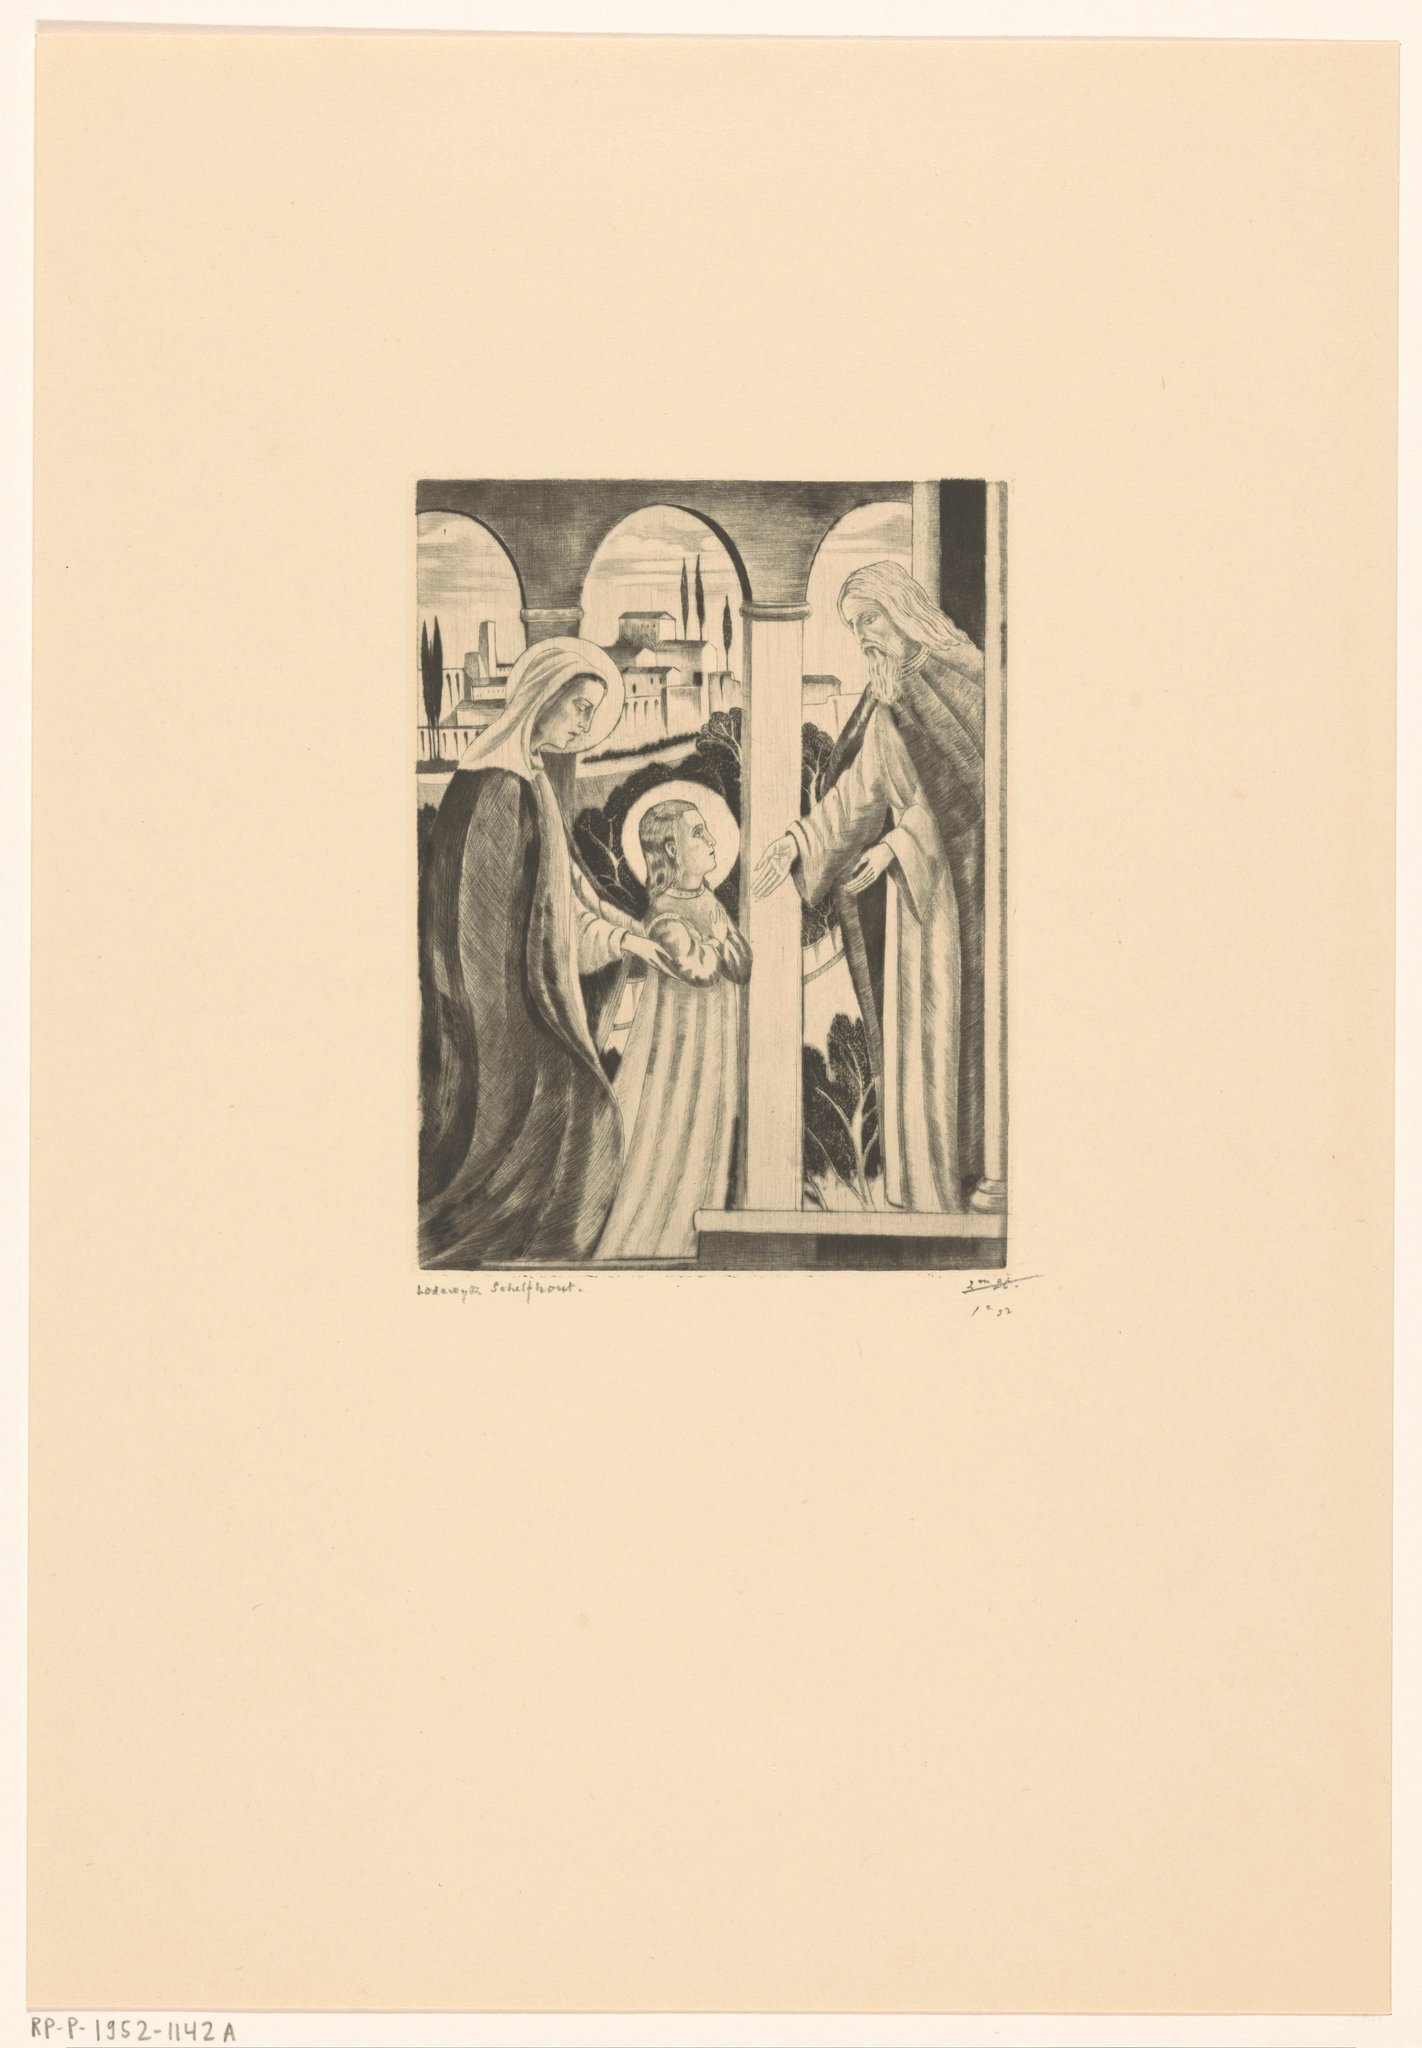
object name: print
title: Opdracht van Maria in de tempel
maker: lodewijk schelfhout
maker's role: draughtsman, print maker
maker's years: 1881-1943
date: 1932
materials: paper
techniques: drypoint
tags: dedication (or presentation) of mary in the temple: she ascends the steps and is received by the high priest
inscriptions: collector's mark: Lugt 2228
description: Maria wordt door haar moeder Anna aan een priester aangeboden als tempelmaagd. Hij ontvangt haar met open armen.